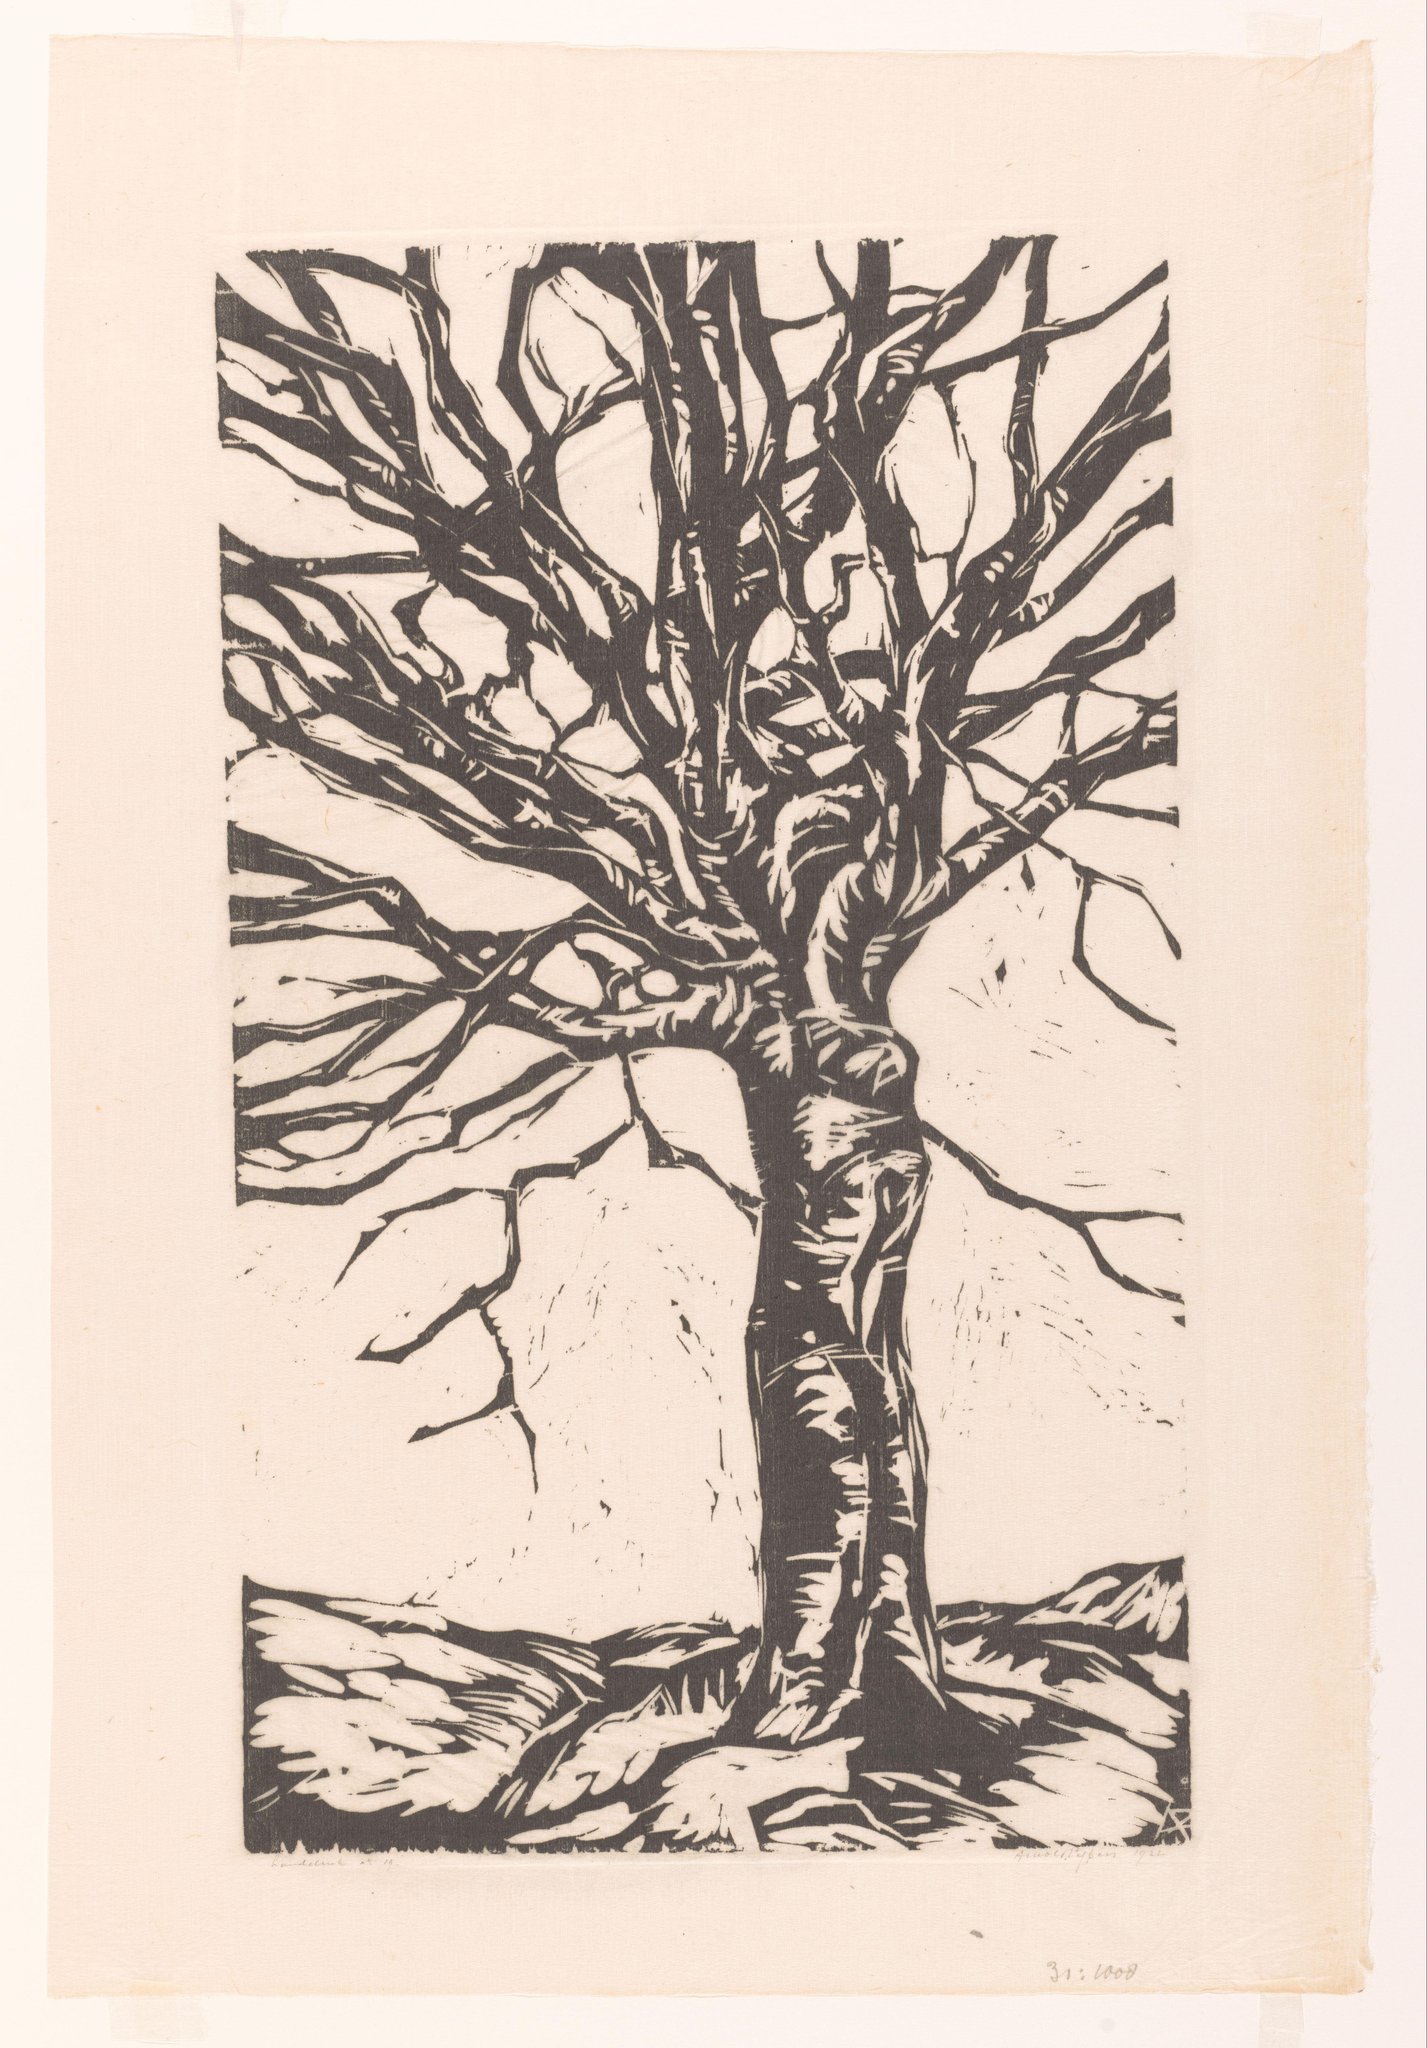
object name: print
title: Kale boom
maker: arnold pijpers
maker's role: print maker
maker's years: 1900-1951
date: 1922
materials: paper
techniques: woodcut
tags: trees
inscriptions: annotation: ‘nr 19’